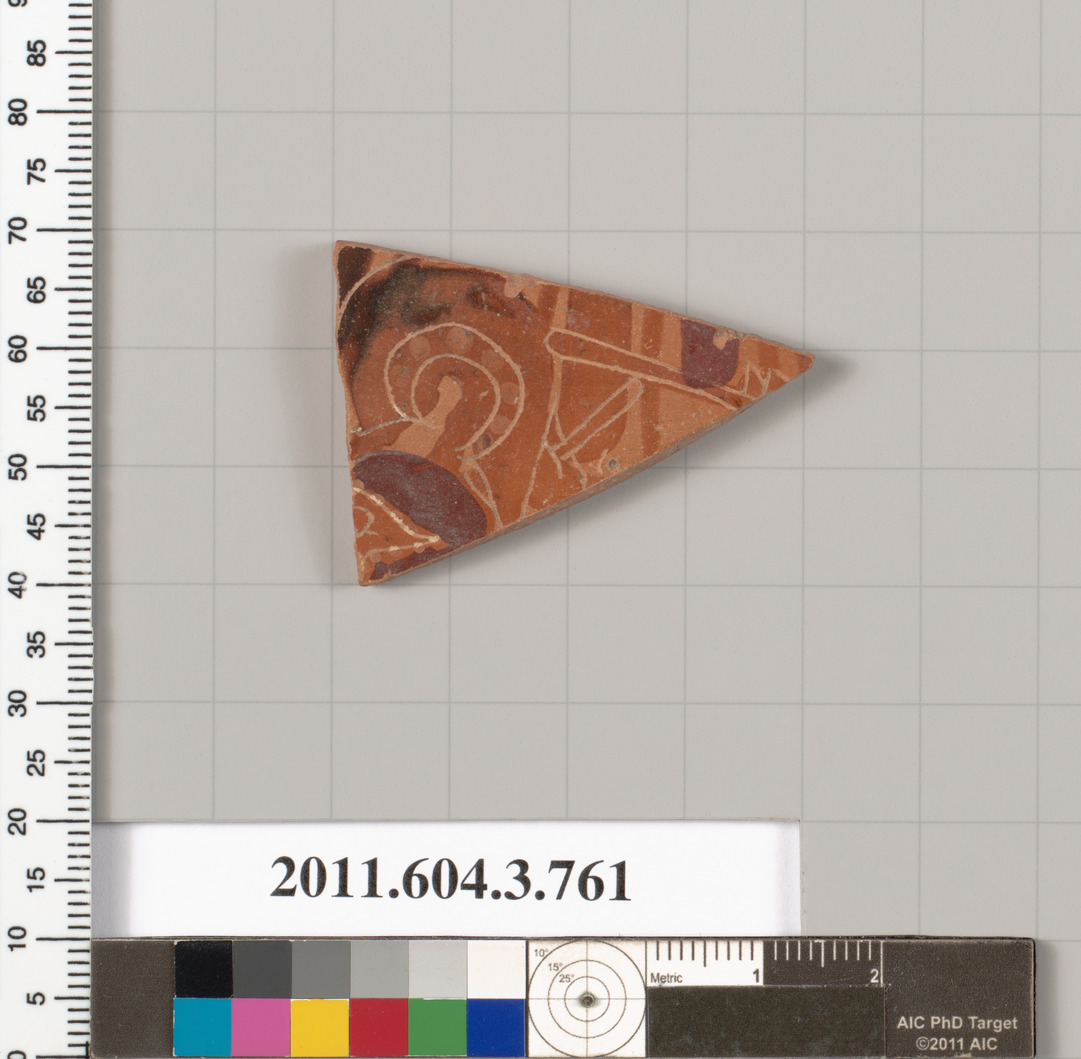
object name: neck amphora, tyrrhenian fragment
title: Terracotta fragment of a neck-amphora (jar)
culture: greek, attic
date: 575-551 BCE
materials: terracotta